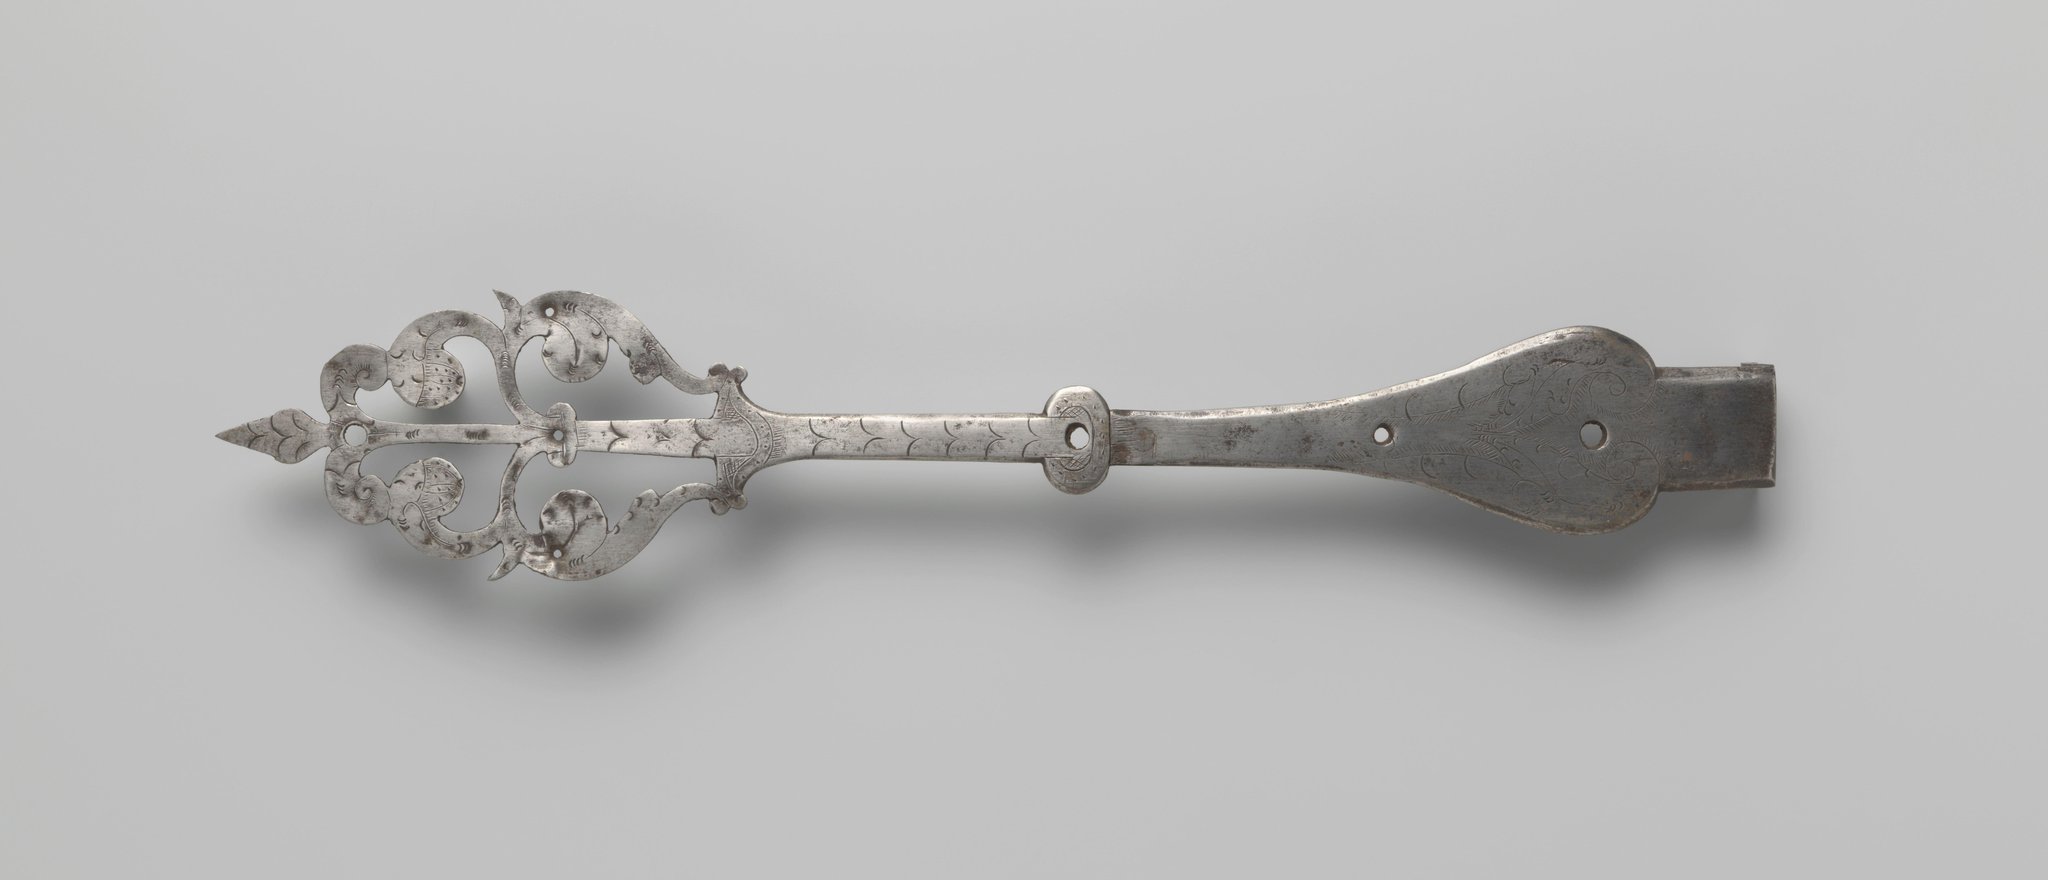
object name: deurhengsel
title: Onderdeel van een deurhengsel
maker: Anonymous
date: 1600-1800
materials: iron, tin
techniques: engraving, forging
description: Deurbeslag van vertind ijzer, onderdeel van een deurhengsel, versierd met graveringen. Het beslag is vanaf het scharnier als volgt: een balustervormig begin, overgaand in een smal, recht stuk waaruit naar het einde toe enkele bladmotieven ontspringen, die als voluten omkrullen. Het geheel eindigt in een puntig blad.